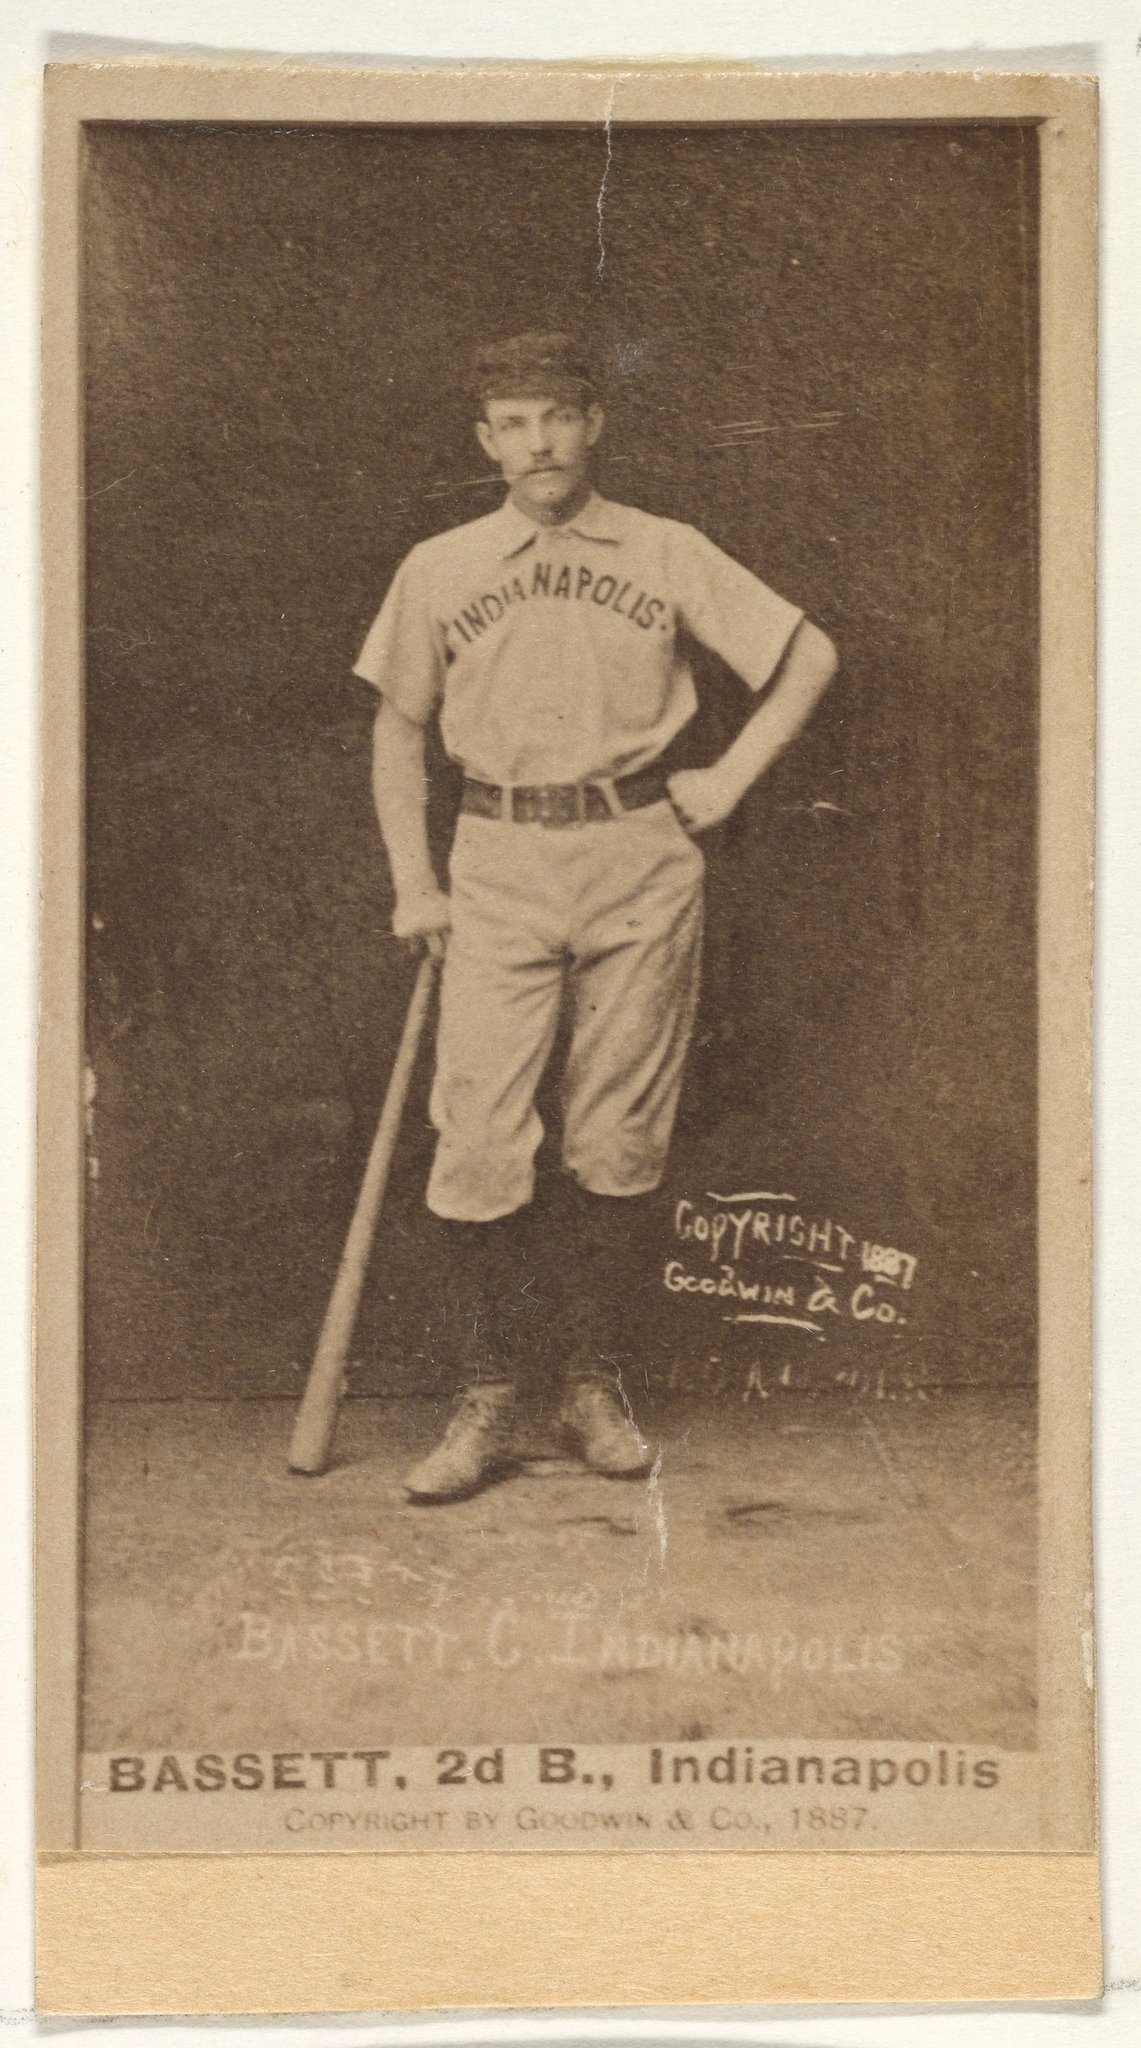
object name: baseball card, photograph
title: Bassett, 2nd Base, Indianapolis, from the Old Judge series (N172) for Old Judge Cigarettes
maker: goodwin & company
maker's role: publisher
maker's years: 1850-1950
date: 1887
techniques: albumen silver print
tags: men,portraits,baseball,athletes